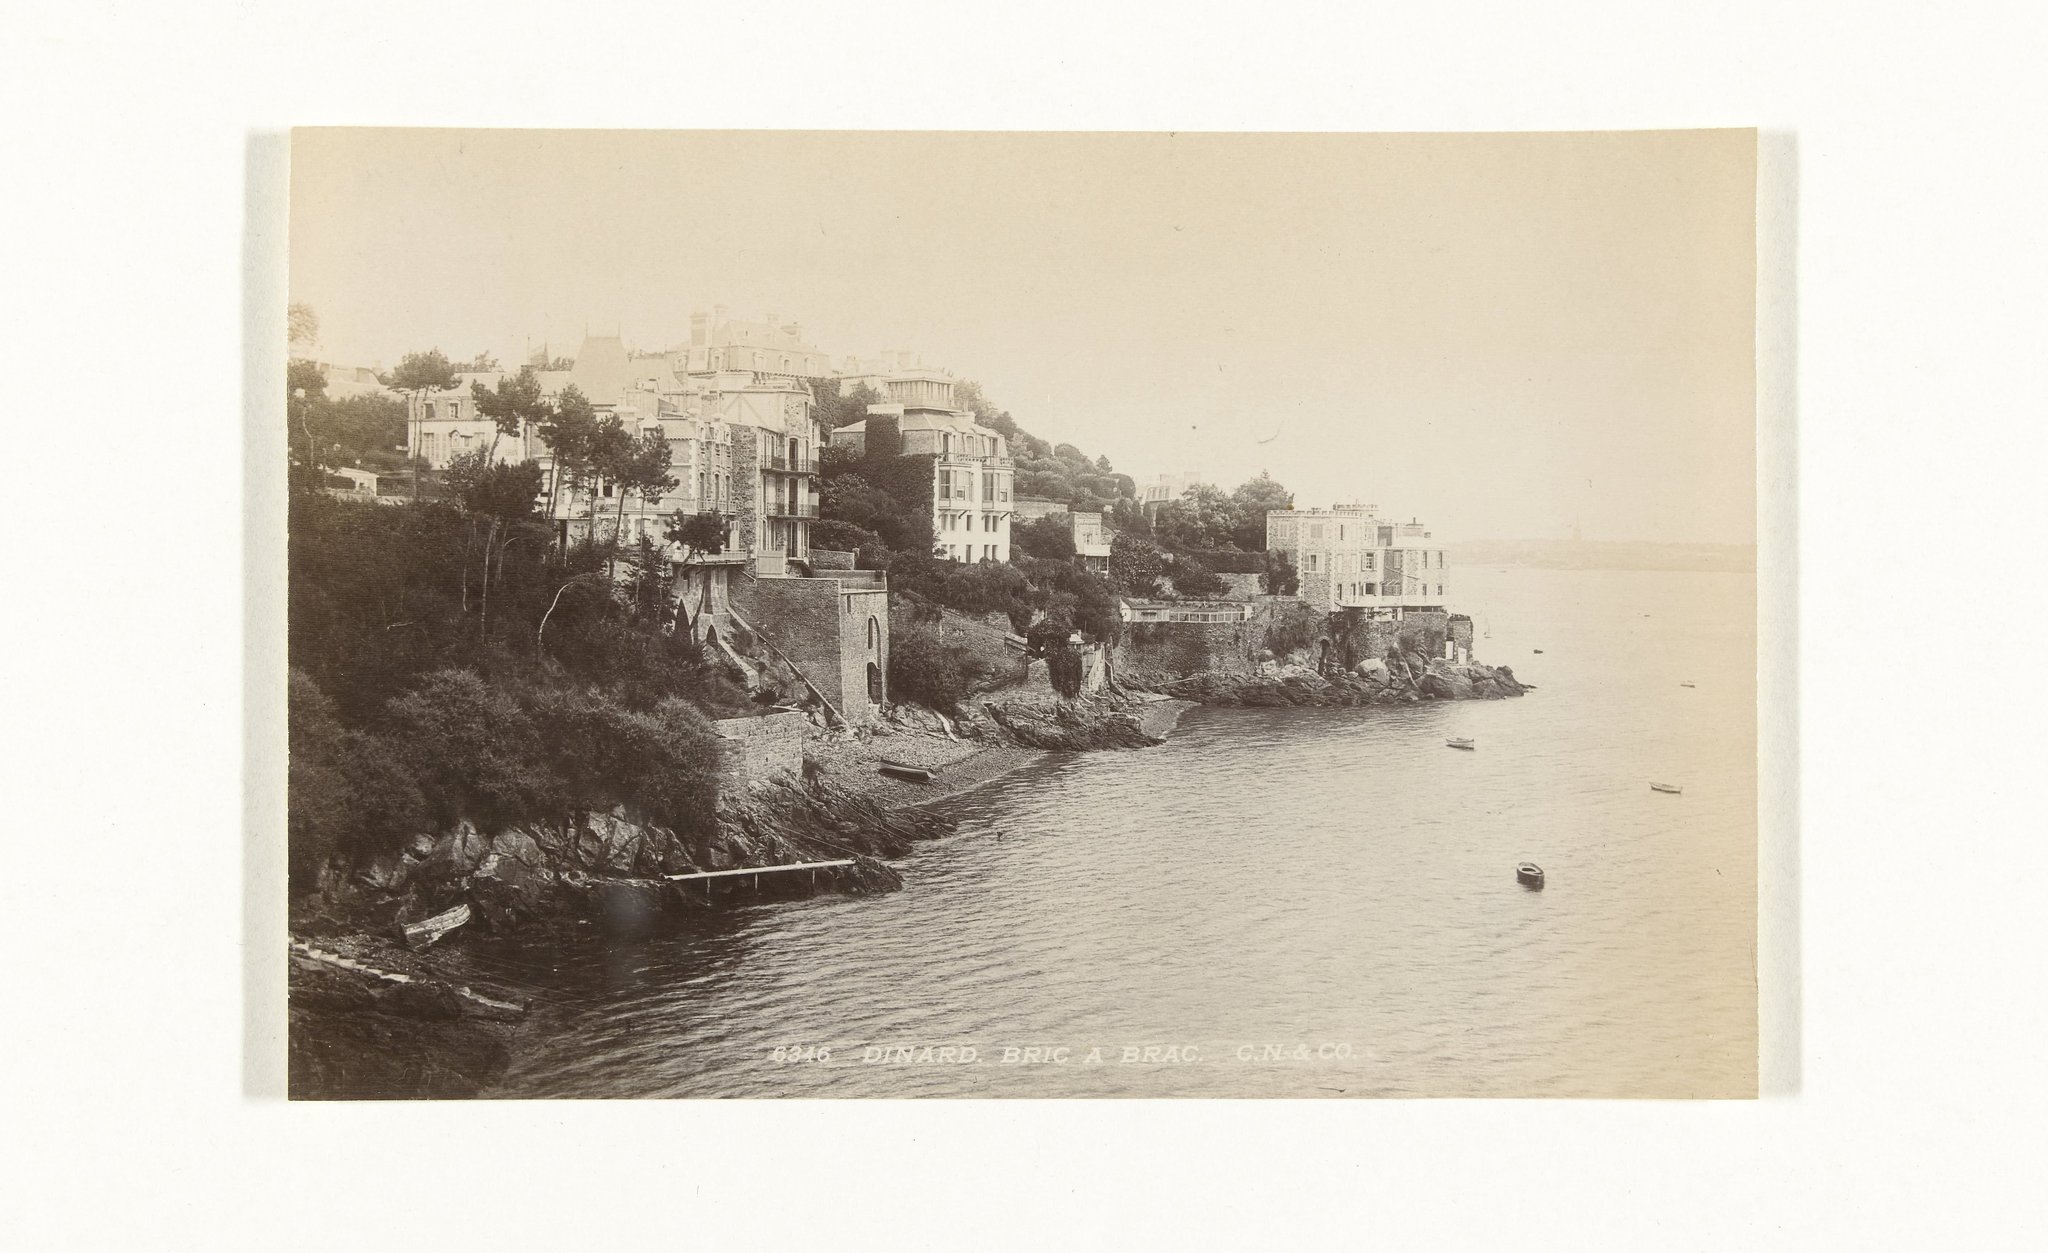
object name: photograph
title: Huizen aan de kust bij Dinard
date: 1880-1900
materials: paper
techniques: collodion silver print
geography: brittany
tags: city-view in general; 'veduta', rocky coast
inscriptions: inscription: ‘6346 Dinard. Bric a Brac. C.N. & Co.’